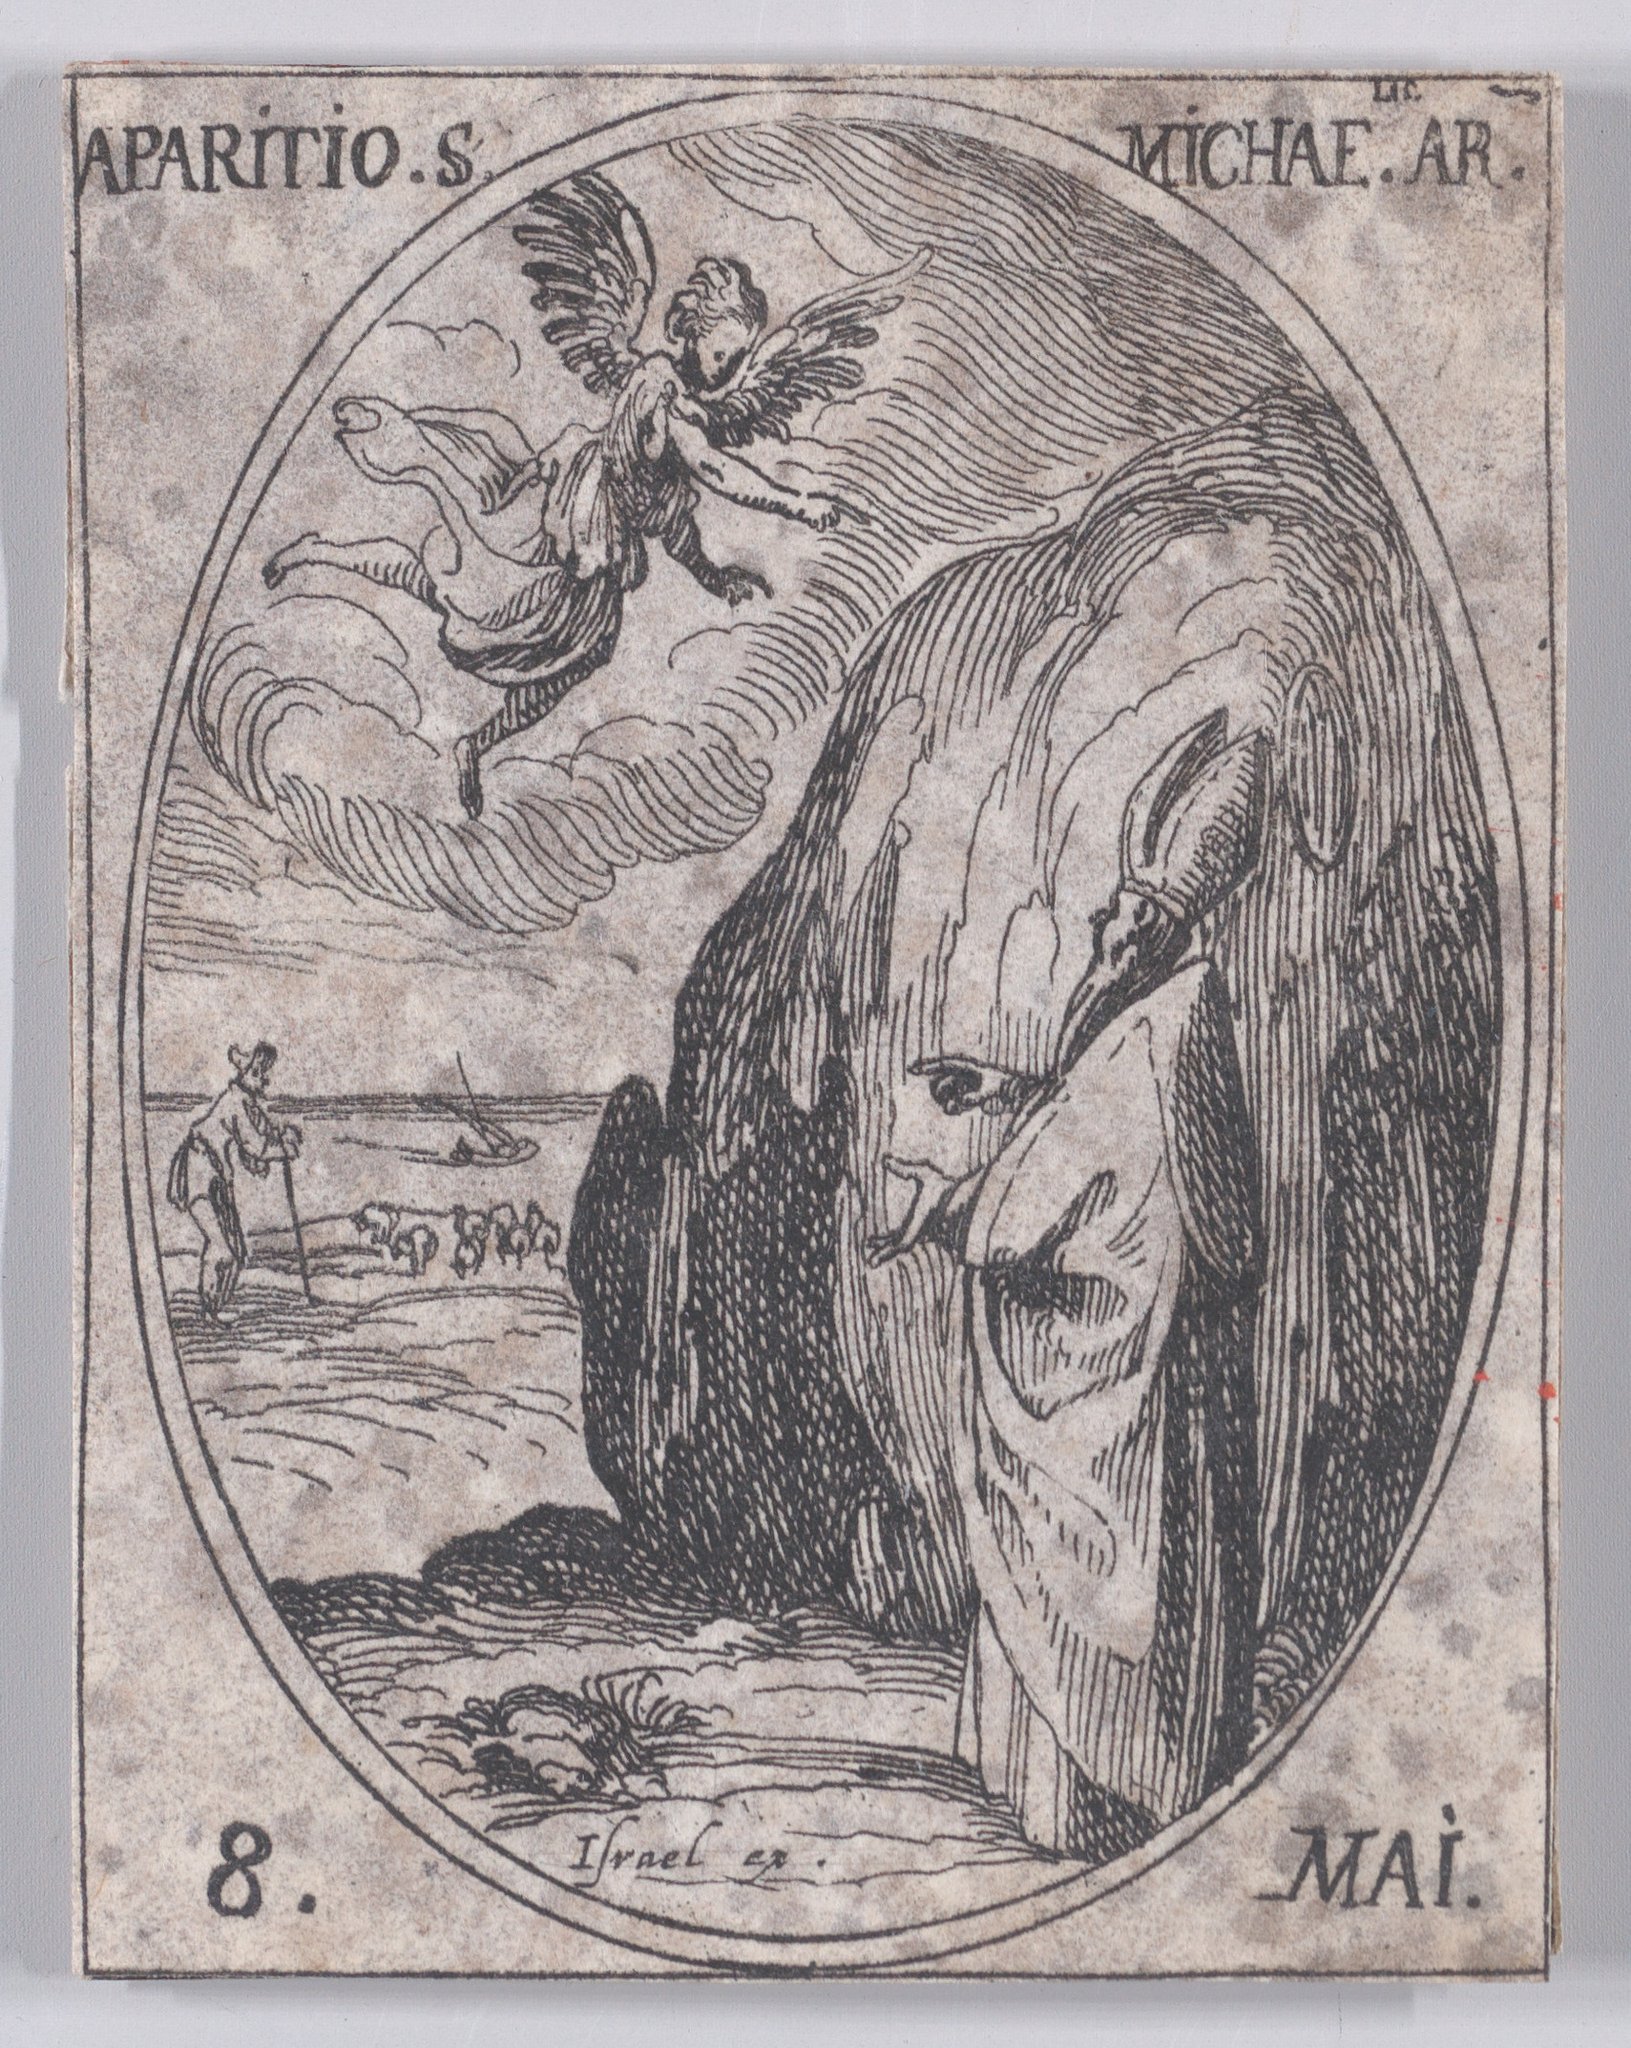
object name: print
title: L'Apparition de S. Michel, archange (The Apparition of St. Michael, Archangel), May 8th, from "Les Images De Tous Les Saincts et Saintes de L'Année" (Images of All of the Saints and Religious Events of the Year)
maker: jacques callot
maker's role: artist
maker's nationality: french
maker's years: 1592-1635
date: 1636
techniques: etching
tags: men,angels,saints